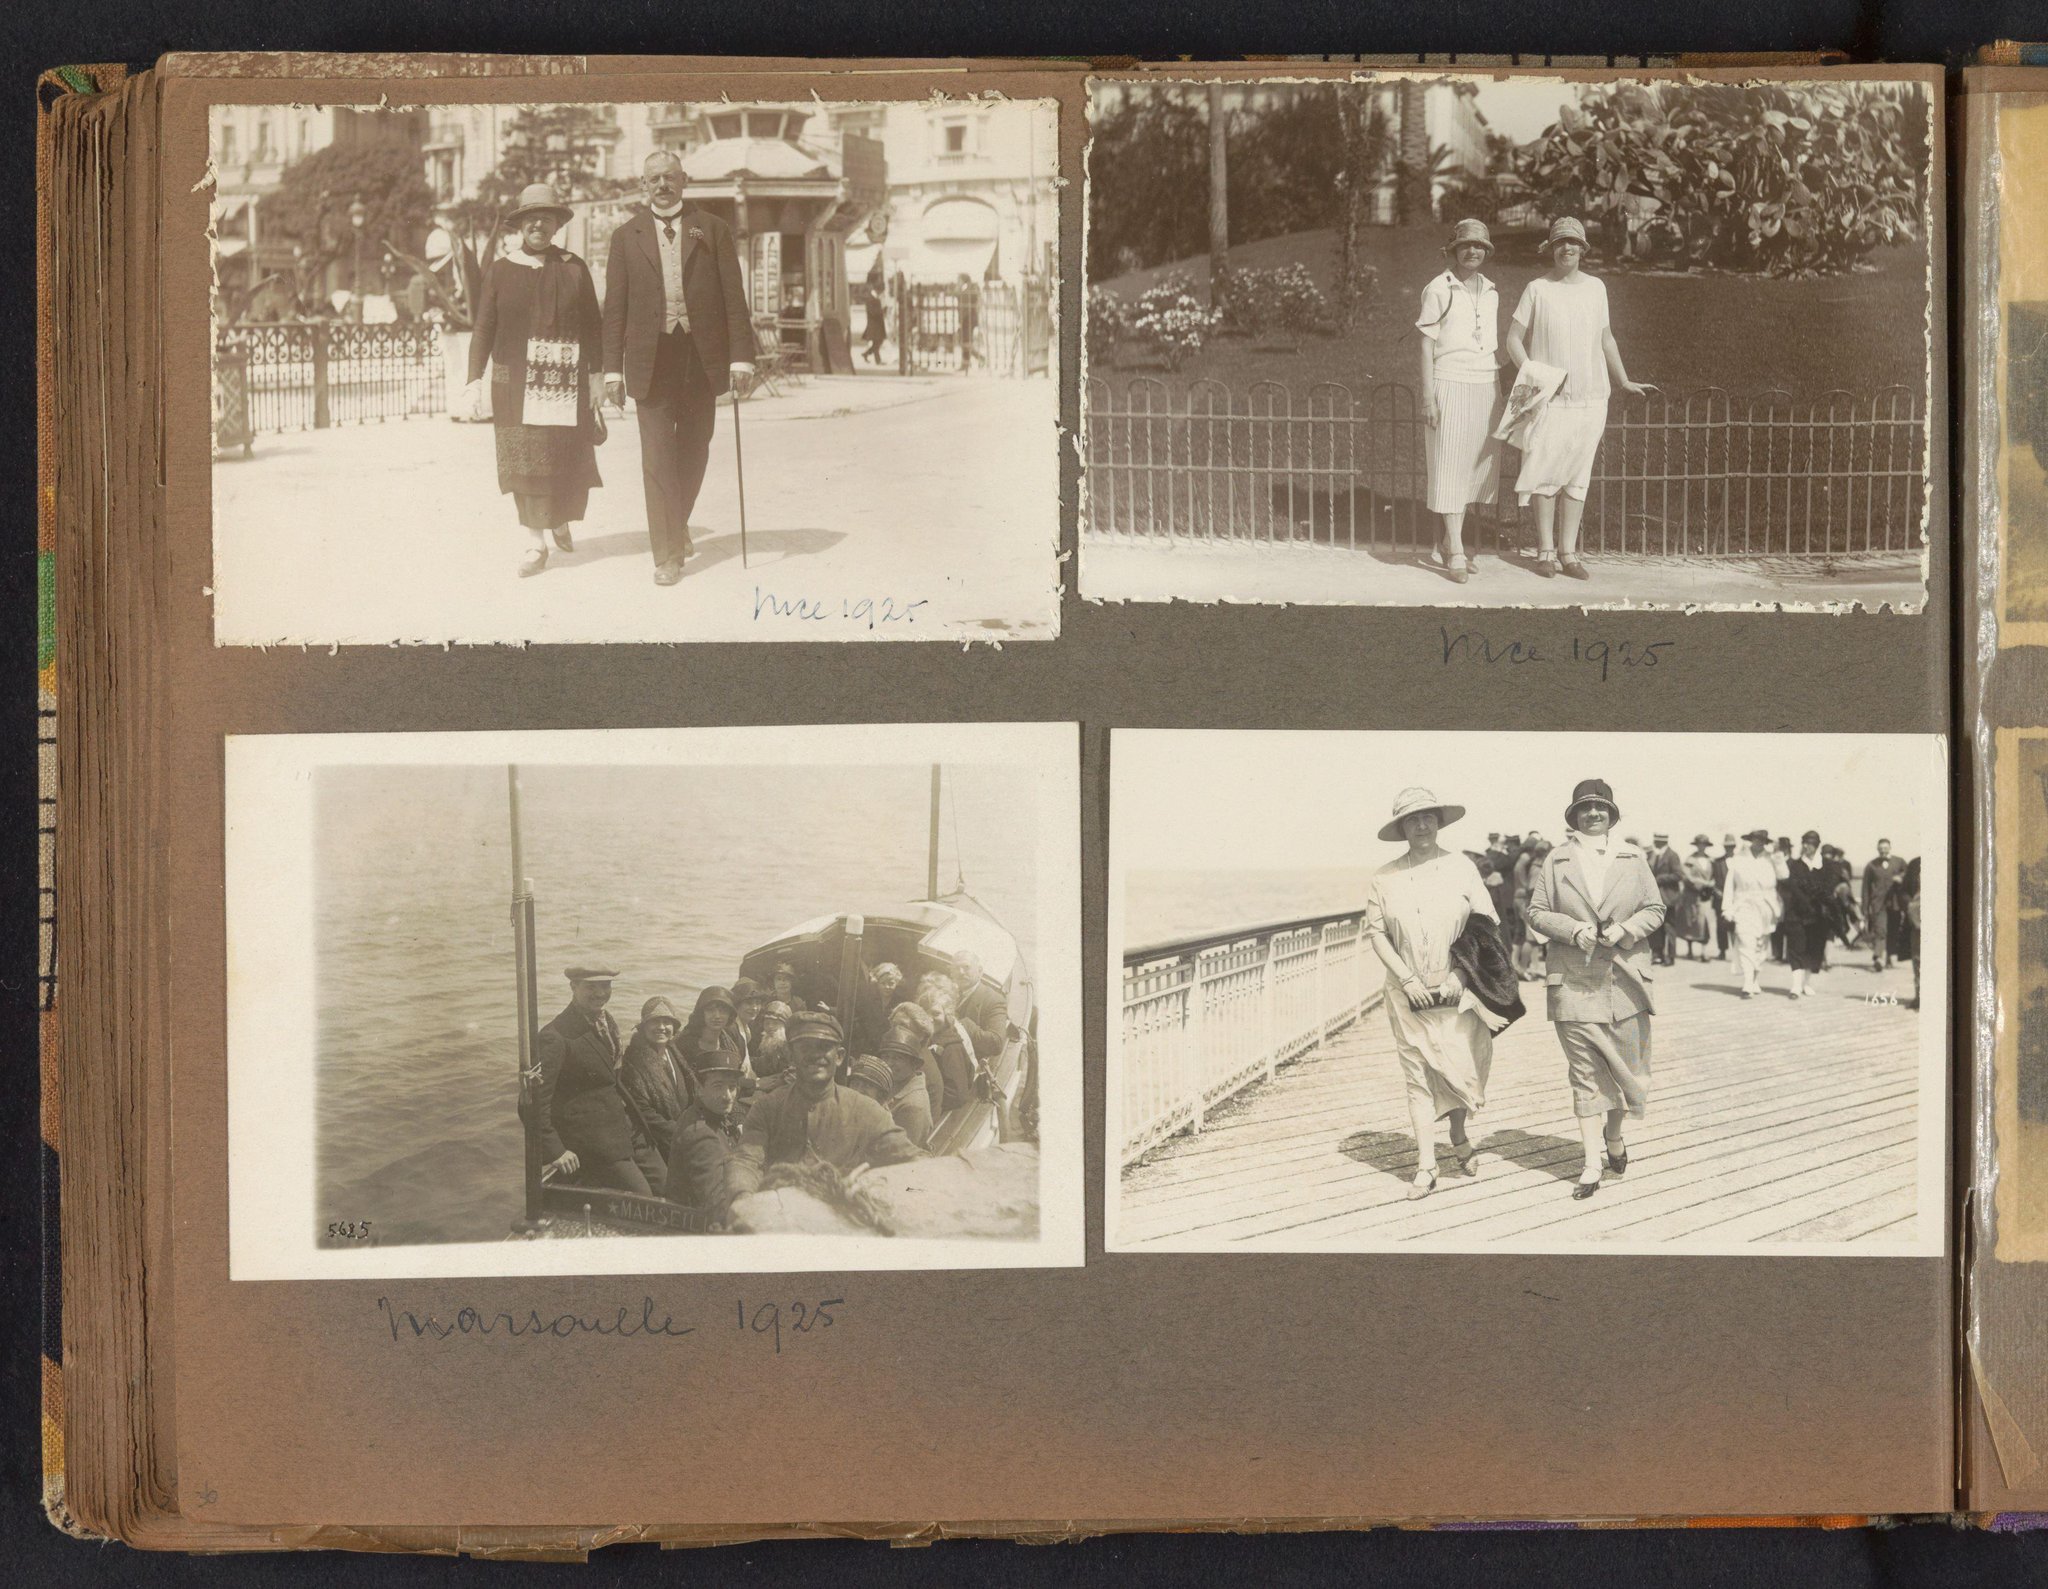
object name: album leaf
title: Verblijf in Nice en Marseille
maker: Anonymous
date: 1900-1925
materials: cardboard, photographic support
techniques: gelatin silver print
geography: nice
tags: adult woman, adult man, rowing-boat, canoe, etc., pier, quay, wharf, street (+ city(-scape) with figures, staffage), marseille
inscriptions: number: ‘5625’, number: ‘1656’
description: Albumblad met foto's van een gezelschap in Nice en Marseille, op straat, in een park en in een boot. Ook een foto van twee vrouwen op de pier van Scheveningen. Onderdeel van Fotoalbum van een onbekende Nederlandse familie met connecties in Suriname en Nederlands-Indië (2).